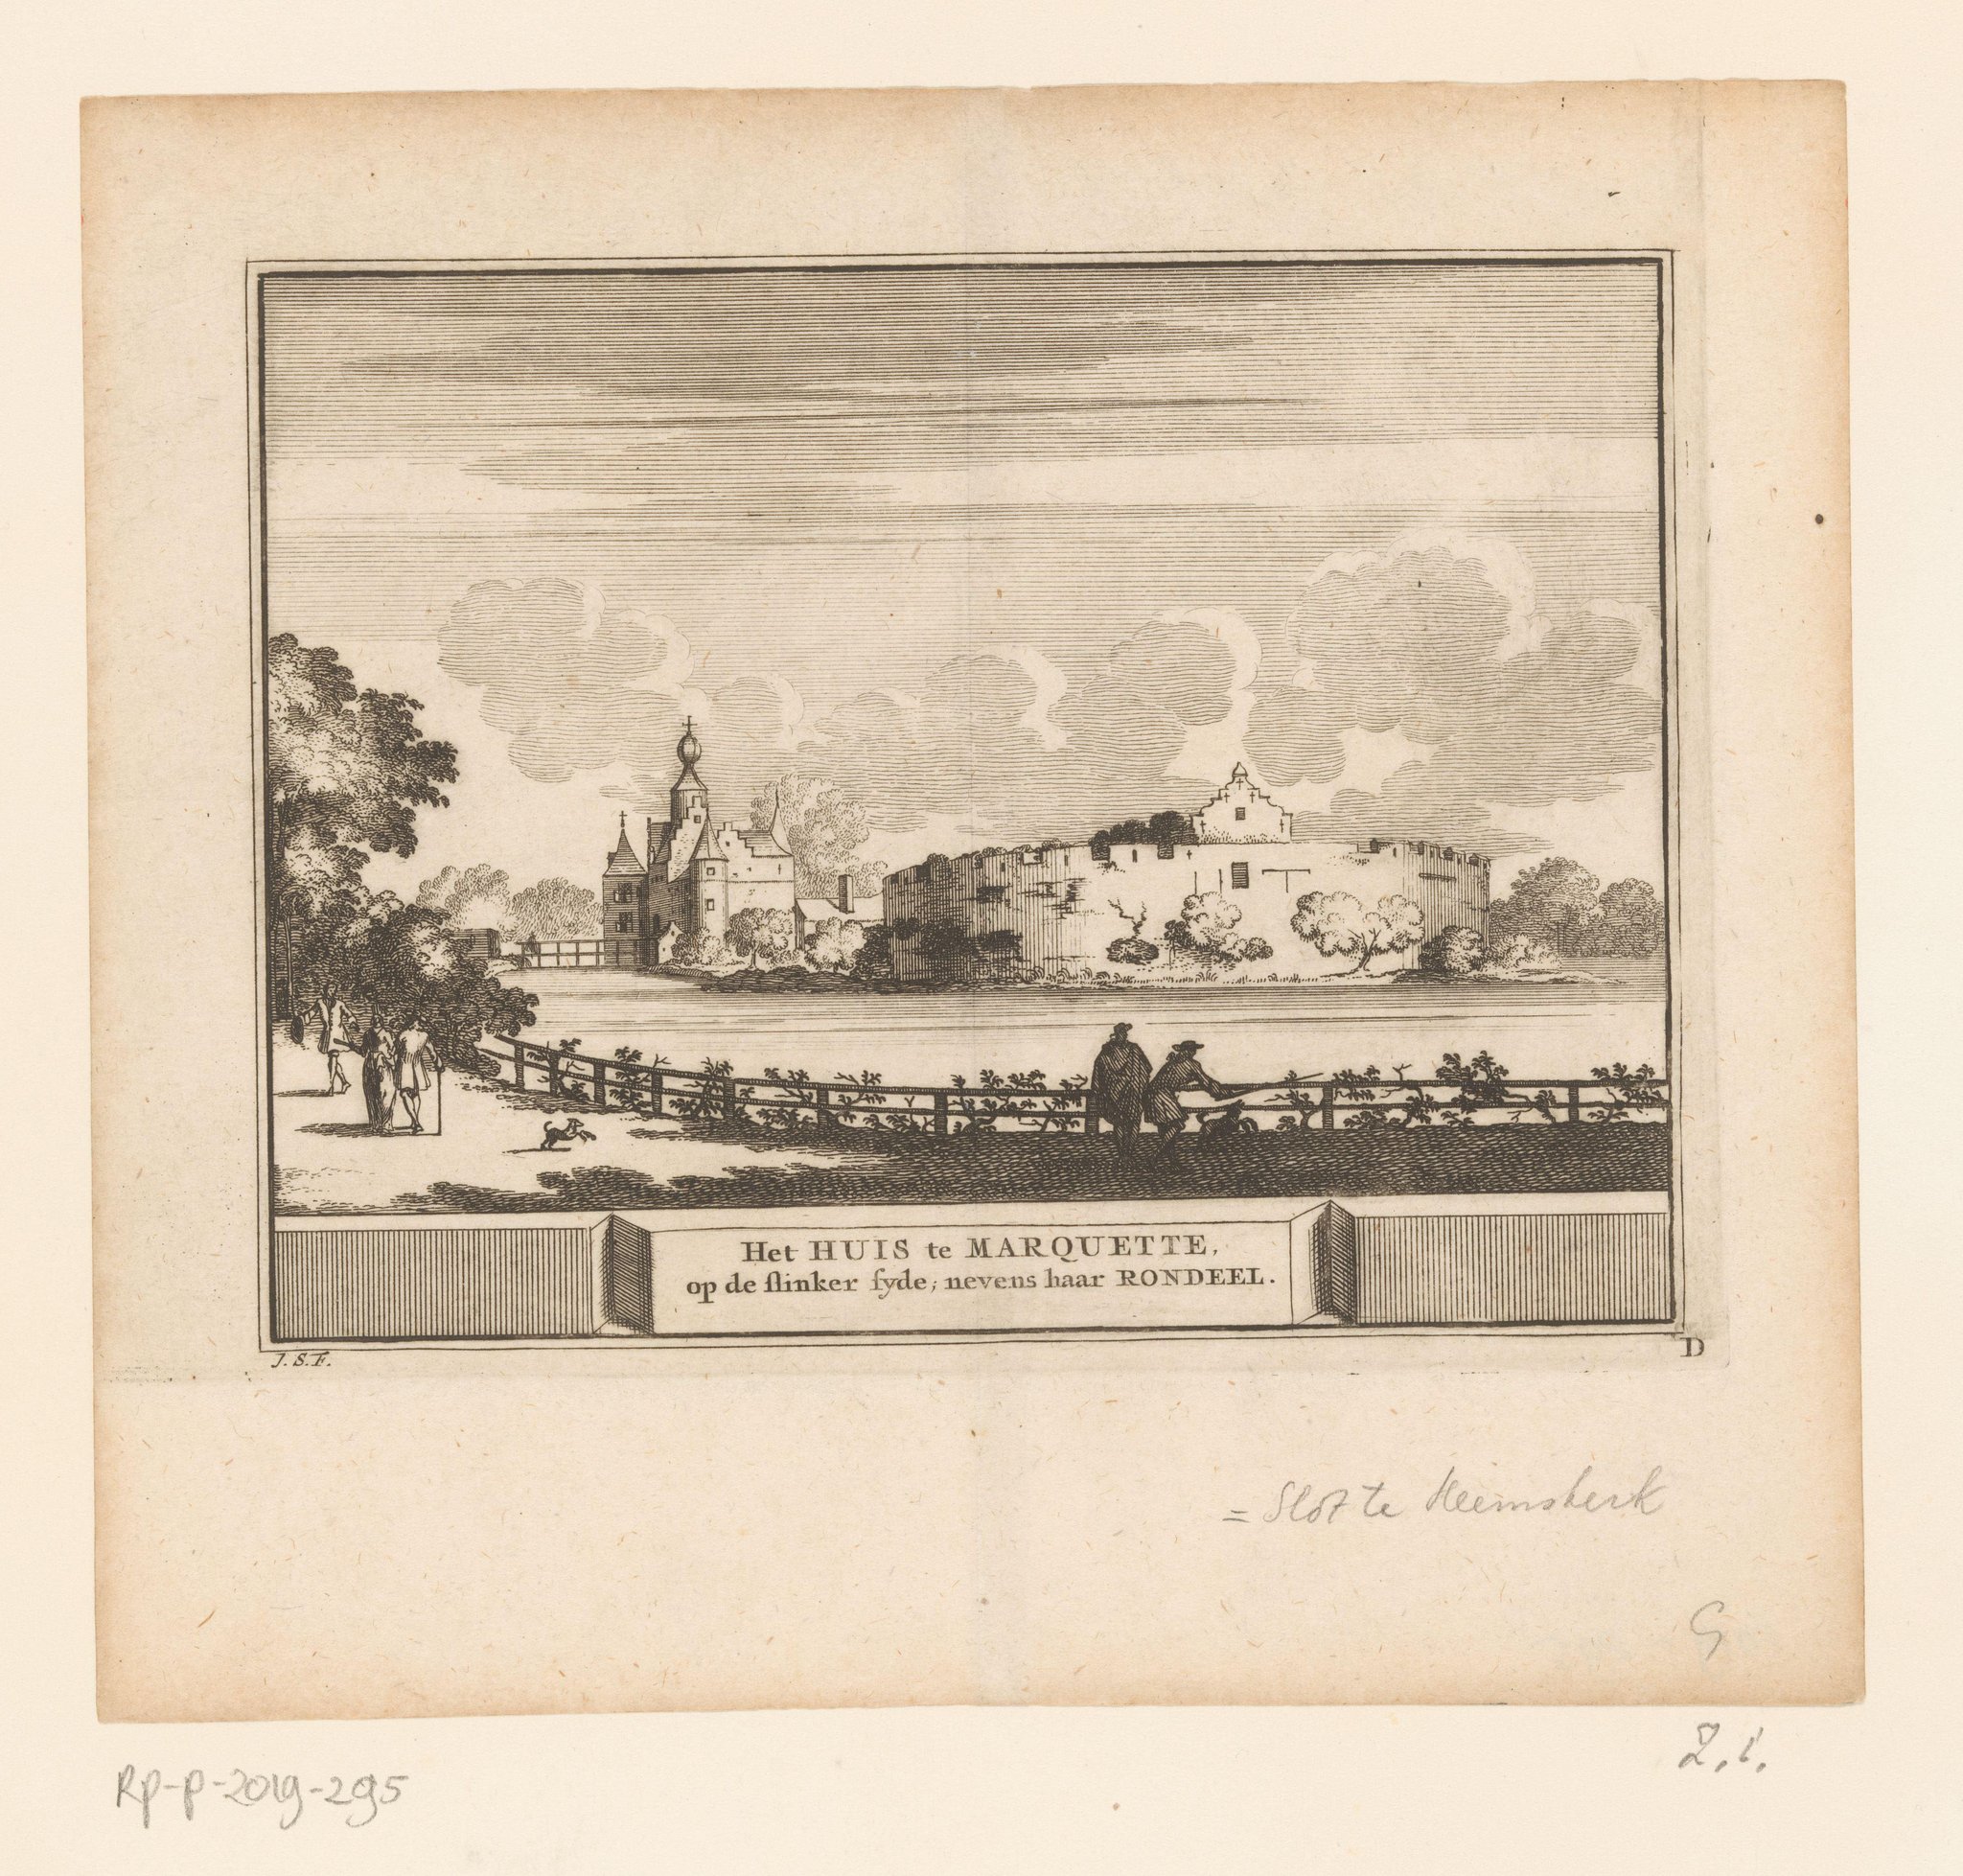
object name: book illustration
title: Het Huis te Marquette op de slinker zyde; nevens haar rondeel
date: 1711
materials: paper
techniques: etching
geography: amsterdam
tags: castle, landscape with tower or castle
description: Prent voor het eerst gebruikt in: Smids, Ludolph. Schatkamer der Nederlandsse oudheden; of Woordenboek, behelsende Nederlands steden. Amsterdam: Pieter de Coup, 1711. Verscheen daarna in heruitgaven van dit werk in 1737 en 1774. In 1721 verscheen er een uitgave met alleen de prenten: Nederlandsche oudheden, bestaande in zestig verbeeldingen (...) gelegen in Holland, 't Sticht van Utrecht en Gelderland enz. Amsterdam: Hendrik Bosch, 1721.